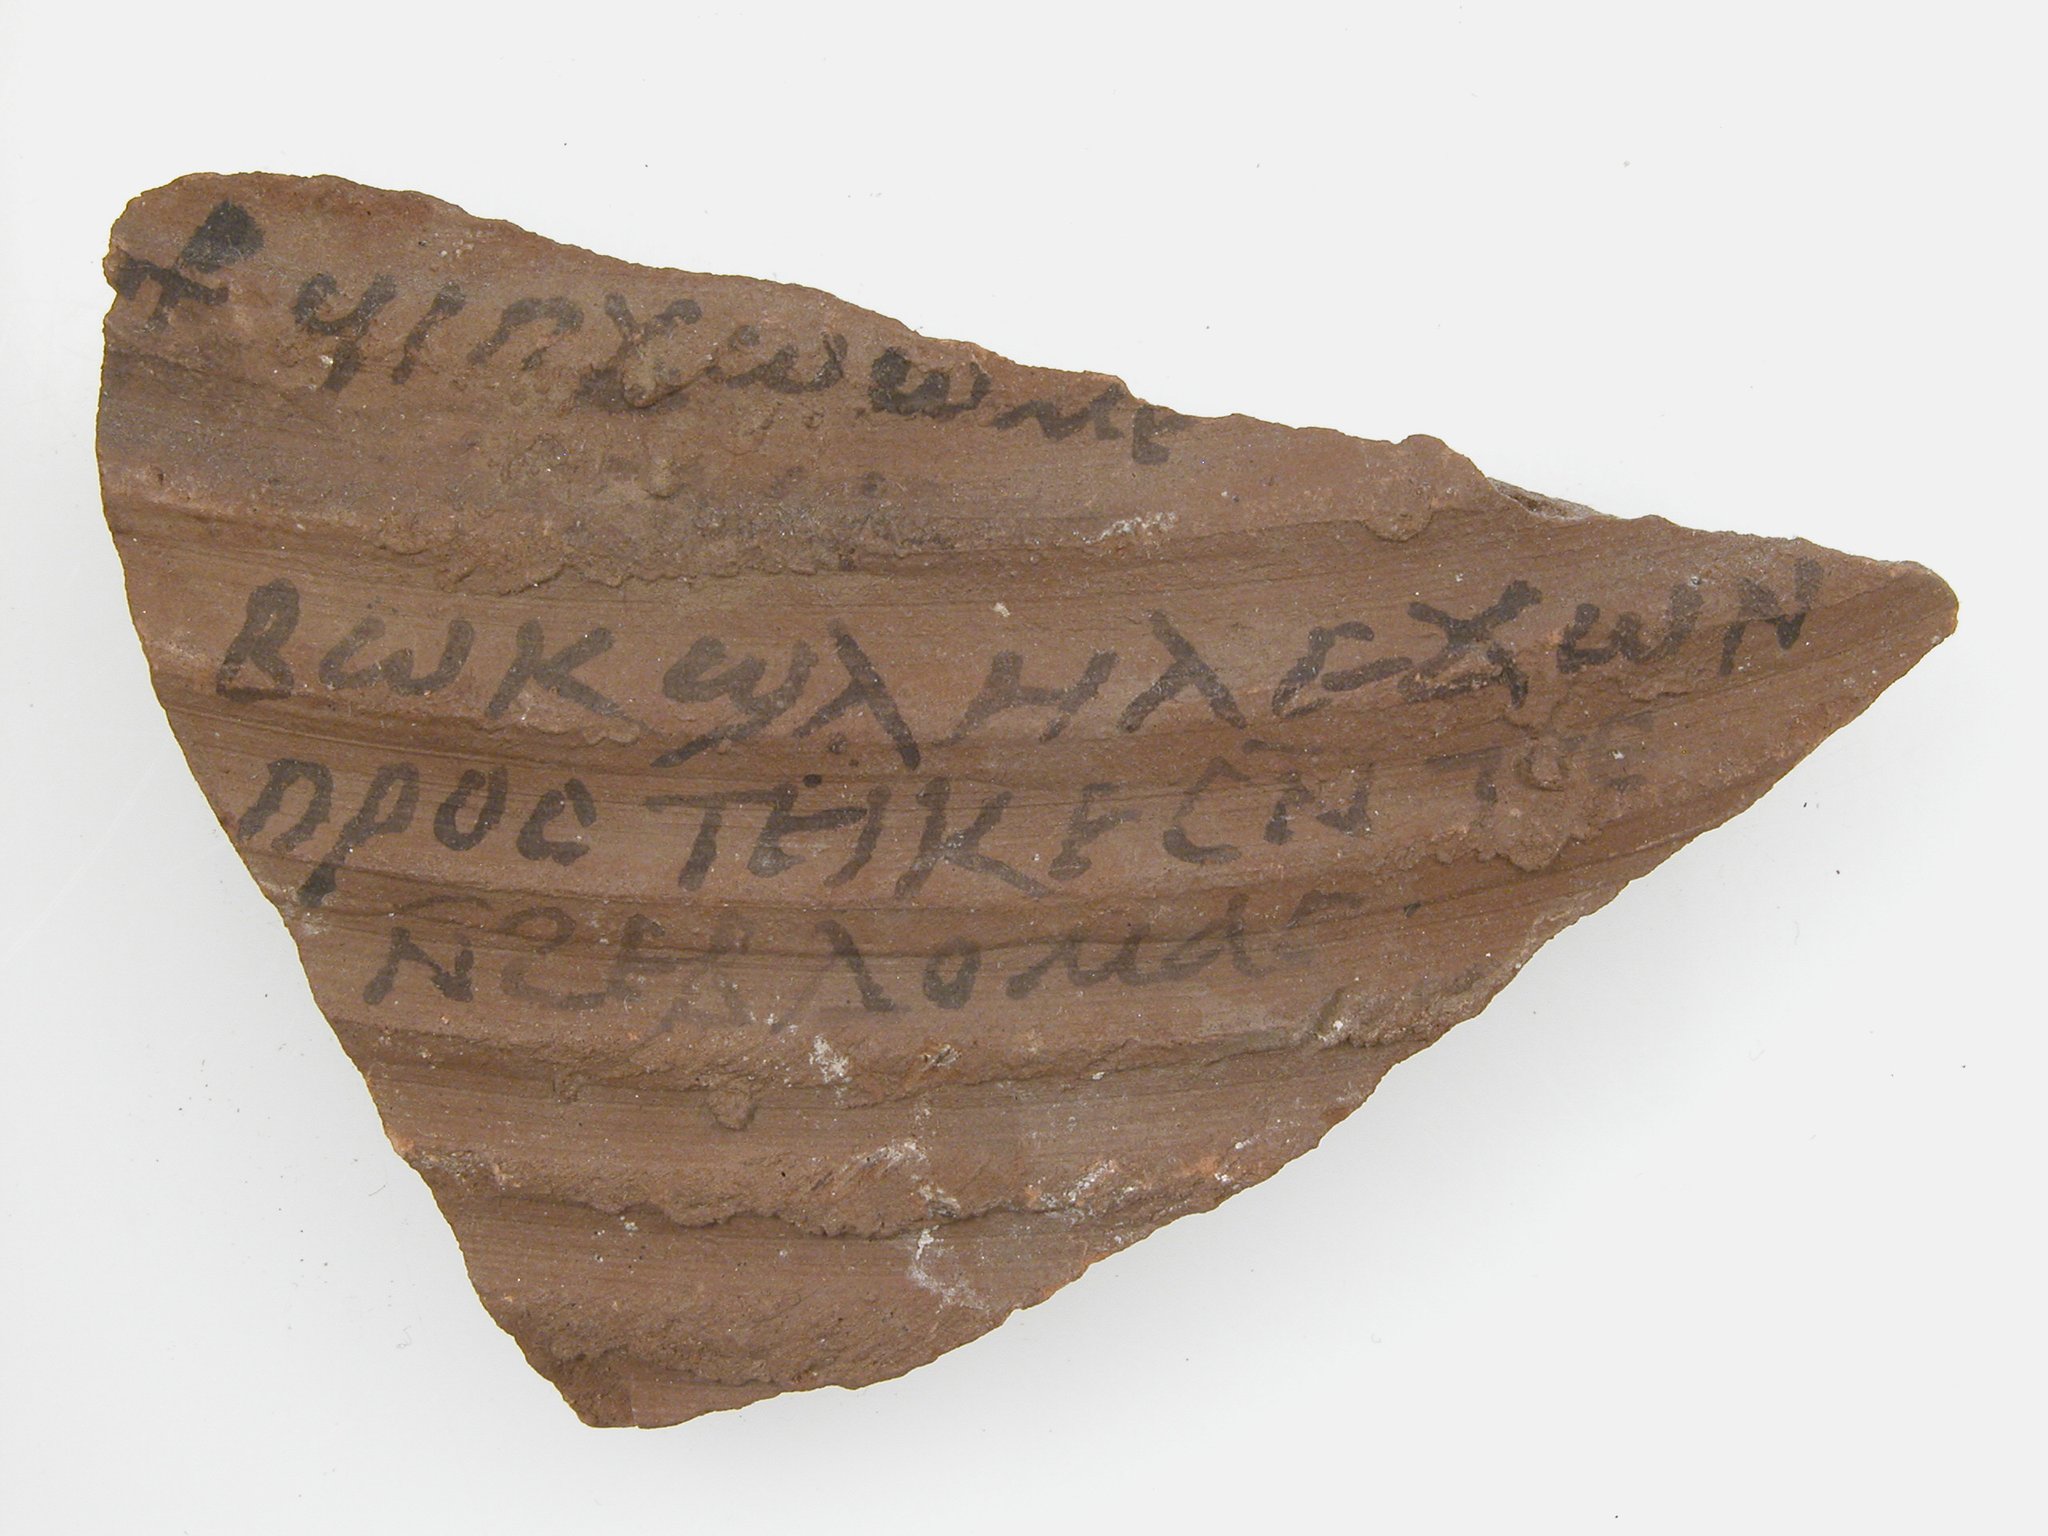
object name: ostrakon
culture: coptic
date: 600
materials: ink, pottery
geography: egypt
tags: coptic,documents